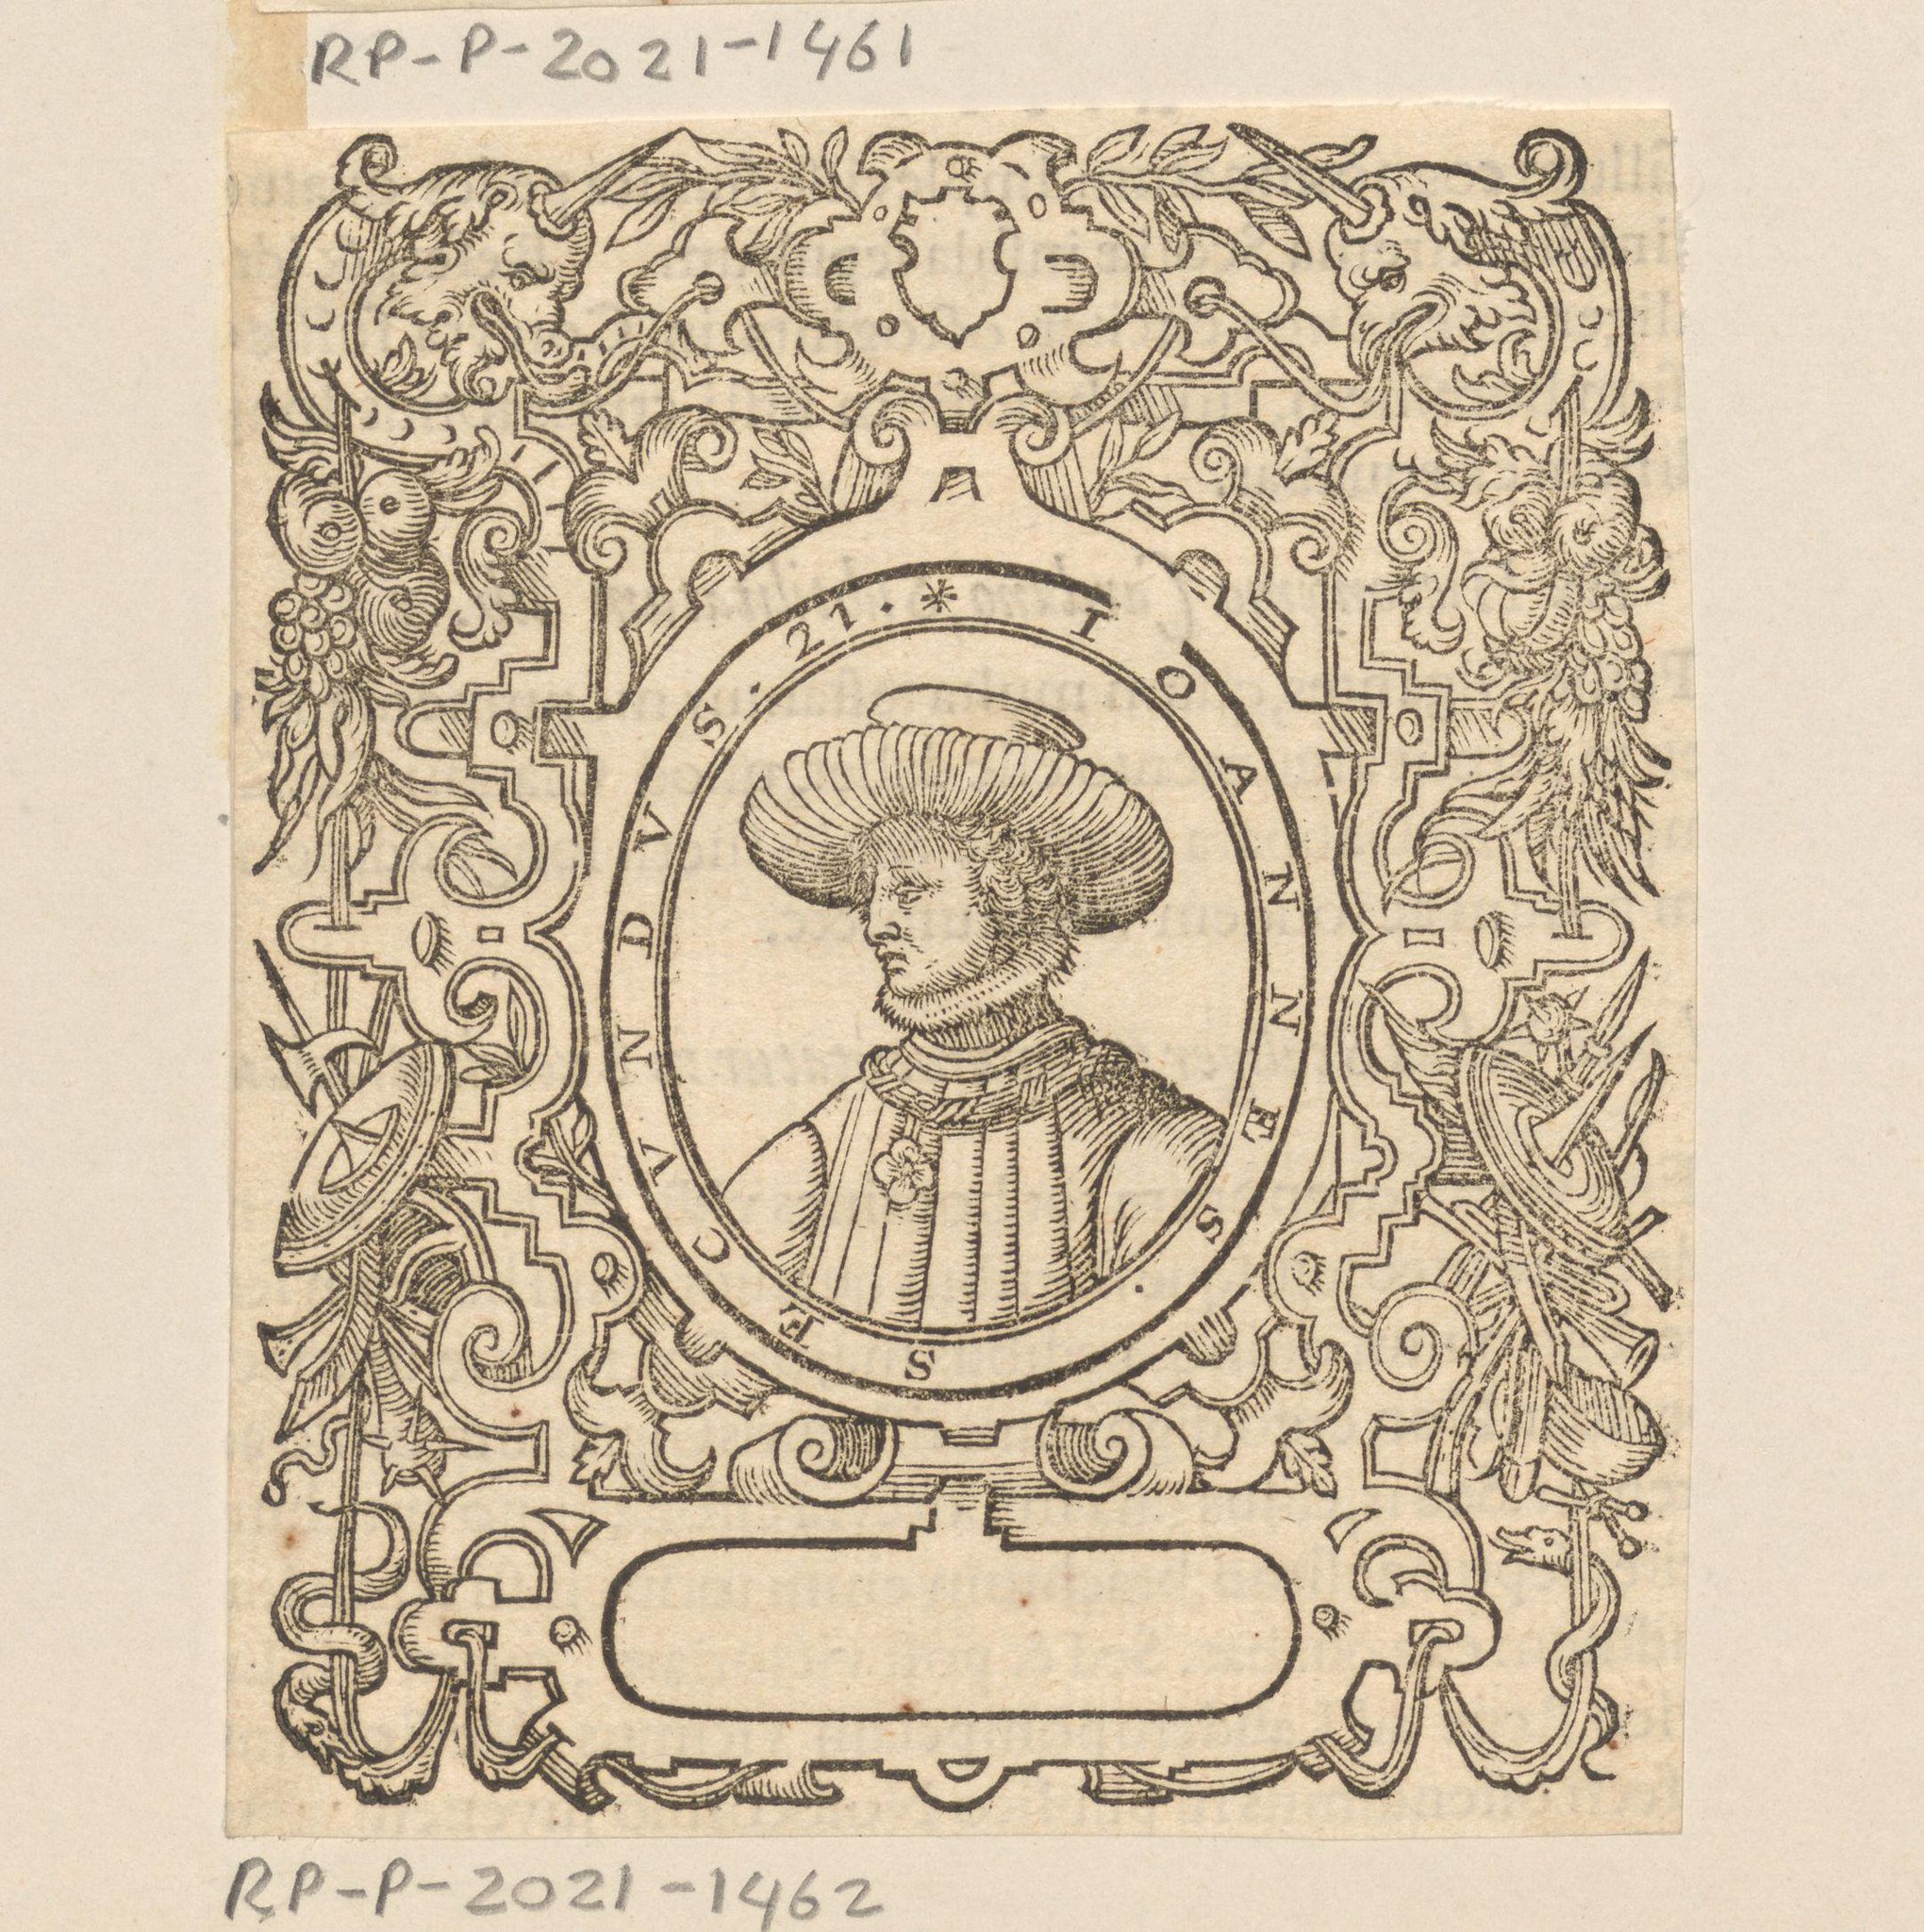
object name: book illustration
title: Portret van Jan II, graaf van Holland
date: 1609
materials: paper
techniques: letterpress printing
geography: leiden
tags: historical persons, ruler, sovereign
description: Prent uit: Illustrissimorum Hollandiae Zelandiaeque comitum ac dominorum Frisiae (...). S.l.s.n., [1609]. Of uit: Scriverius, Petrus. Batavia Illustrata Seu de Batavorum Insula (...). Leiden: Lowijs Elzevier, 1609.